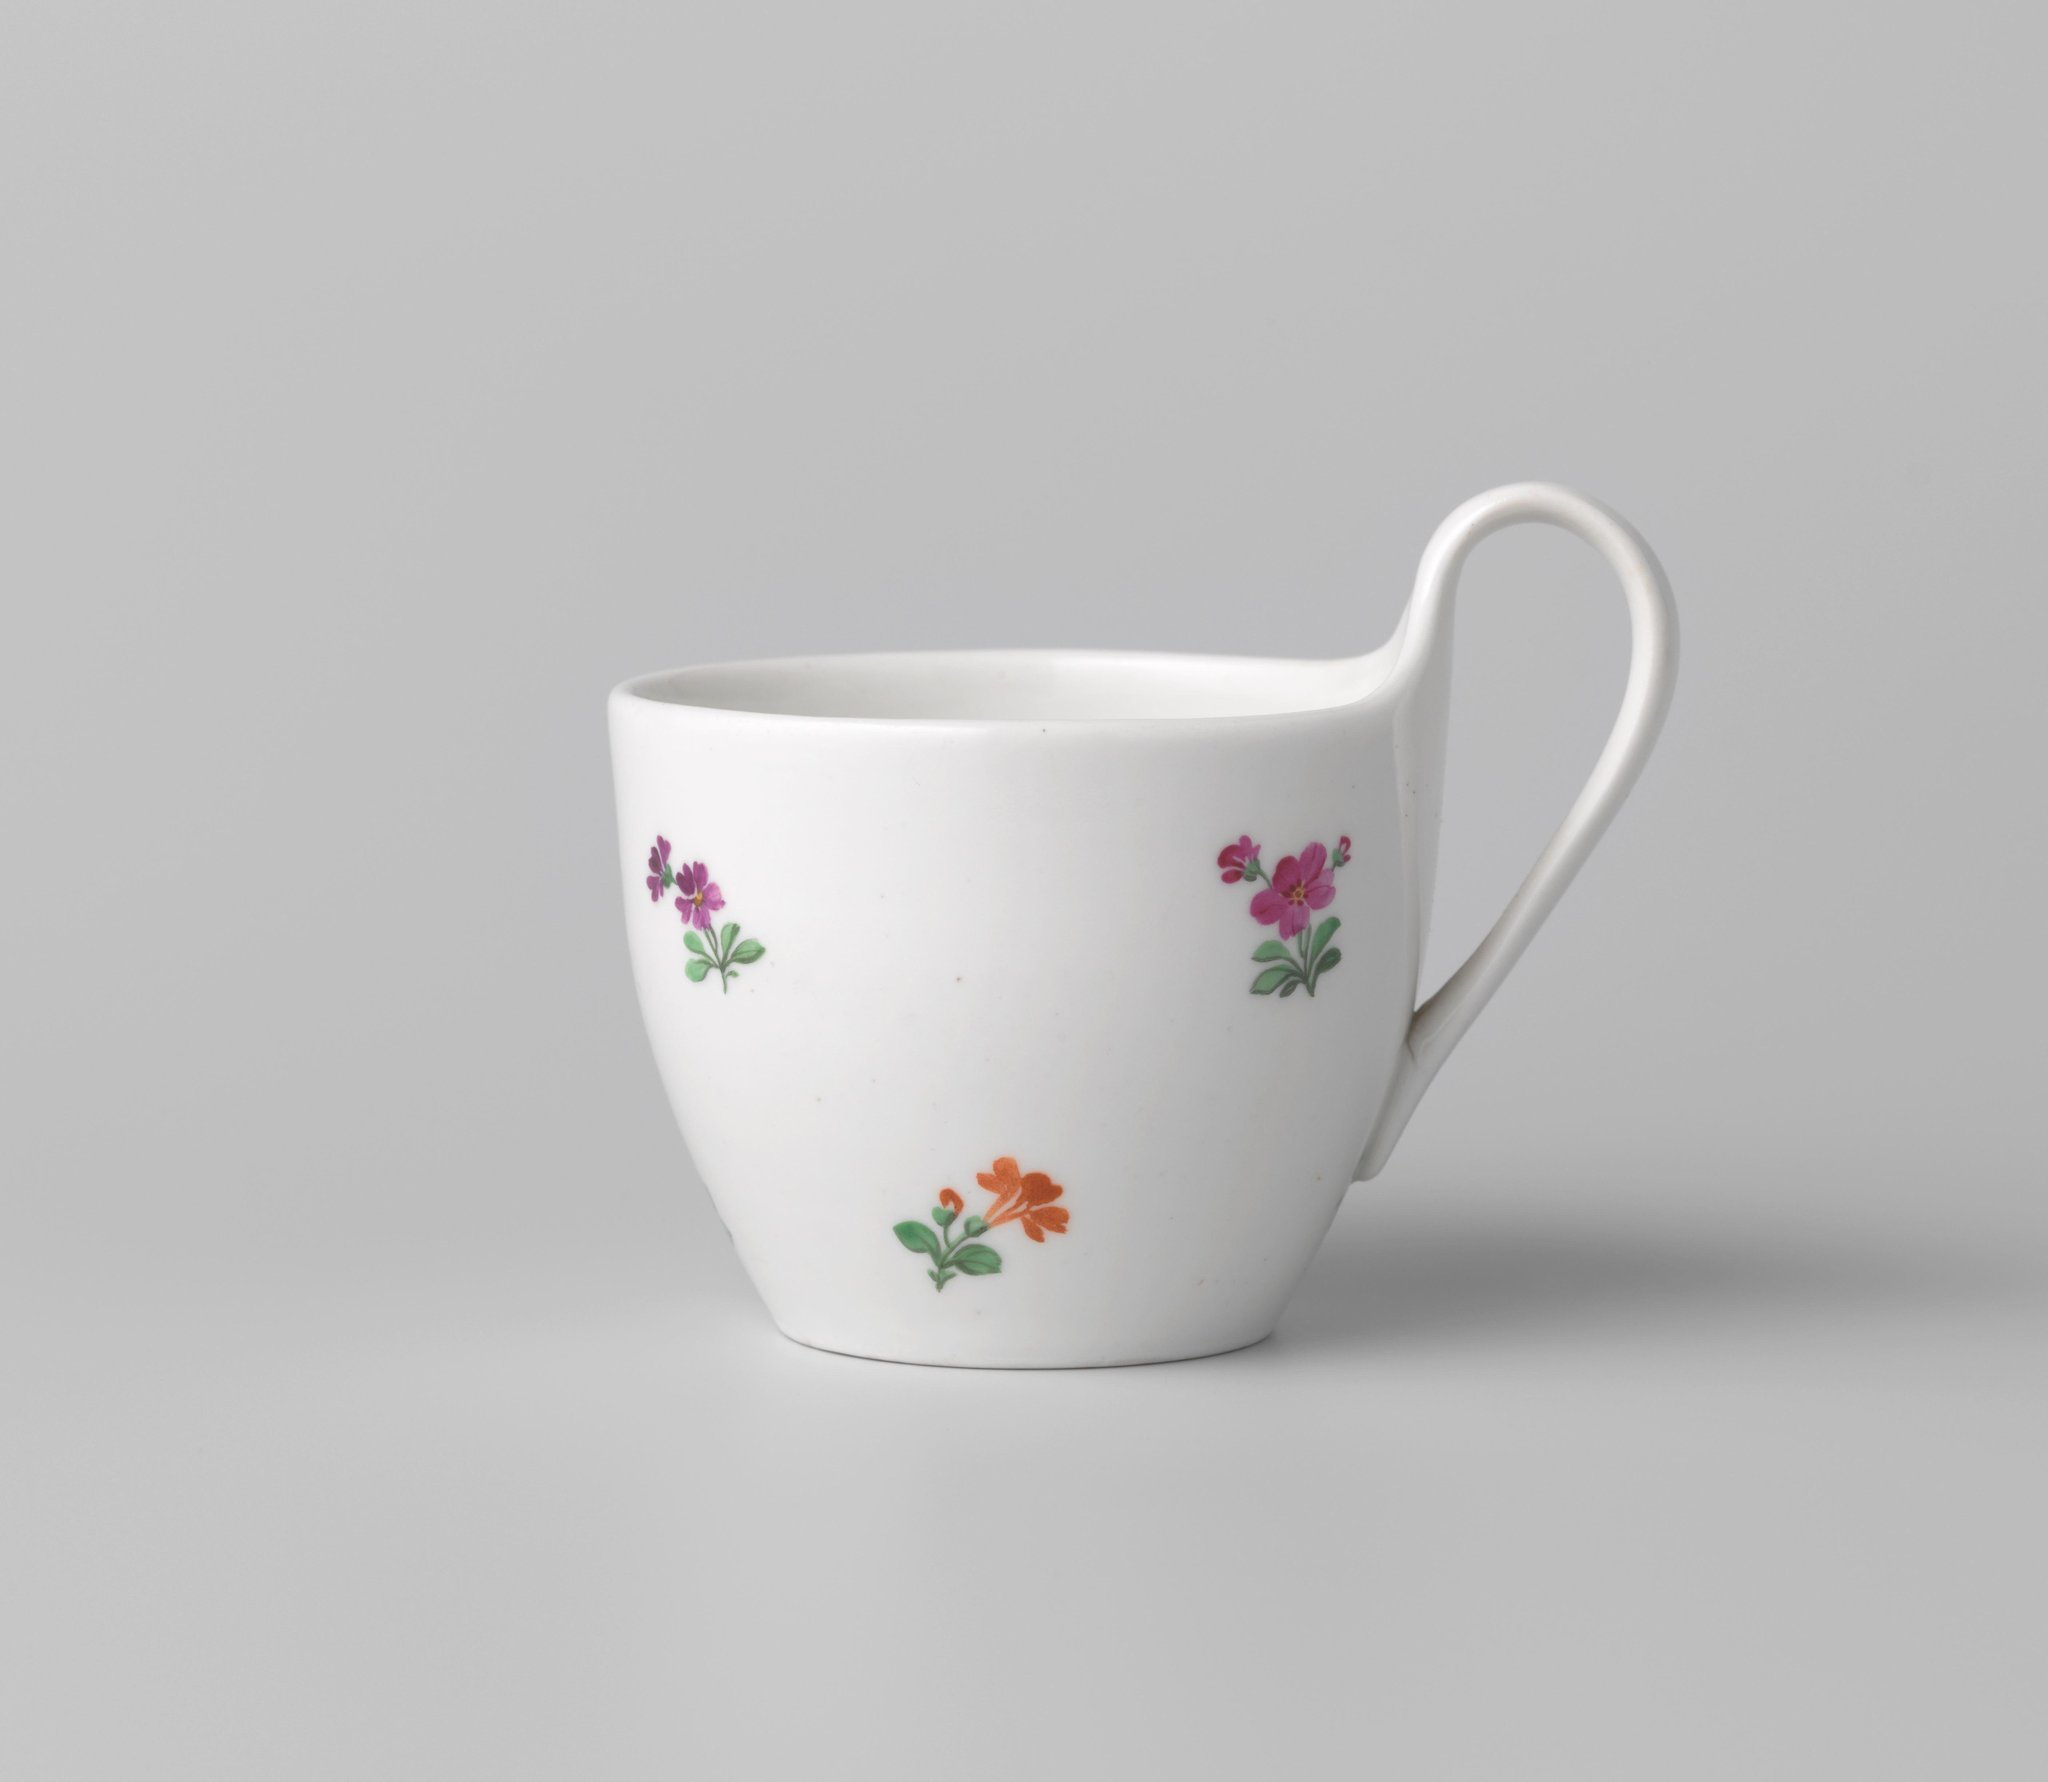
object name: cup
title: Cup with flowers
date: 1849-1870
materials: glaze, paint, porcelain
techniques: firing, turning, vitrification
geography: berlin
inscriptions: mark: ‘scepter met adelaar in medaillon en KOENIGL. PORZELLAN MANUFAKTUR/ II’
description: Kop van porselein, beschilderd op het glazuur in blauw, rood, roze, groen, geel, paars en zwart. Iets ronde wand en hoog, ongelijk C-vormig oor. De buitenwand is bedekt met kleine strooibloemen. De binnenzijde is ongedecoreerd. Gemerkt op de onderzijde met de scepter waaronder een medaillon met de adelaar, een scepter en een globe in zijn klauwen. Het randschrift leest 'KOENIGL. PORZELLAN MANUFAKTUR'. Hierbij II.